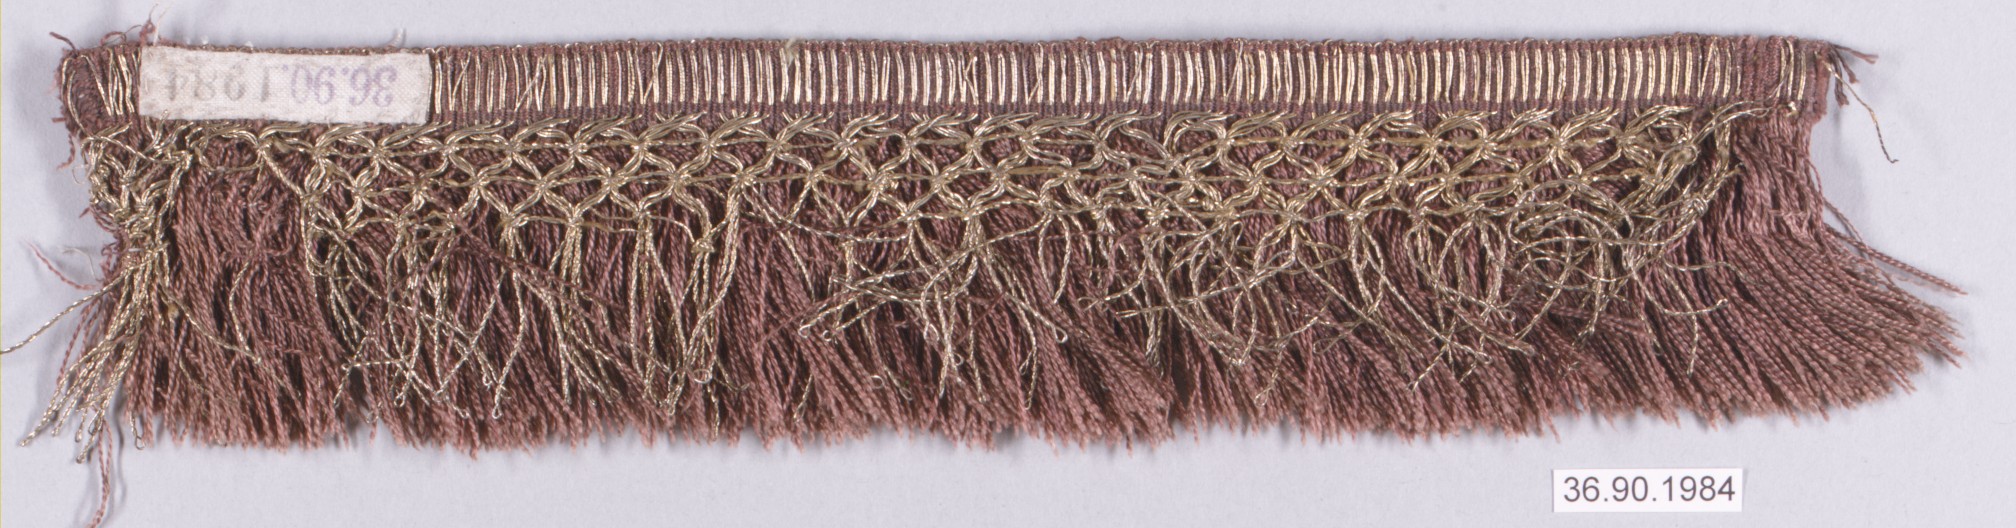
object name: fringe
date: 1750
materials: silk